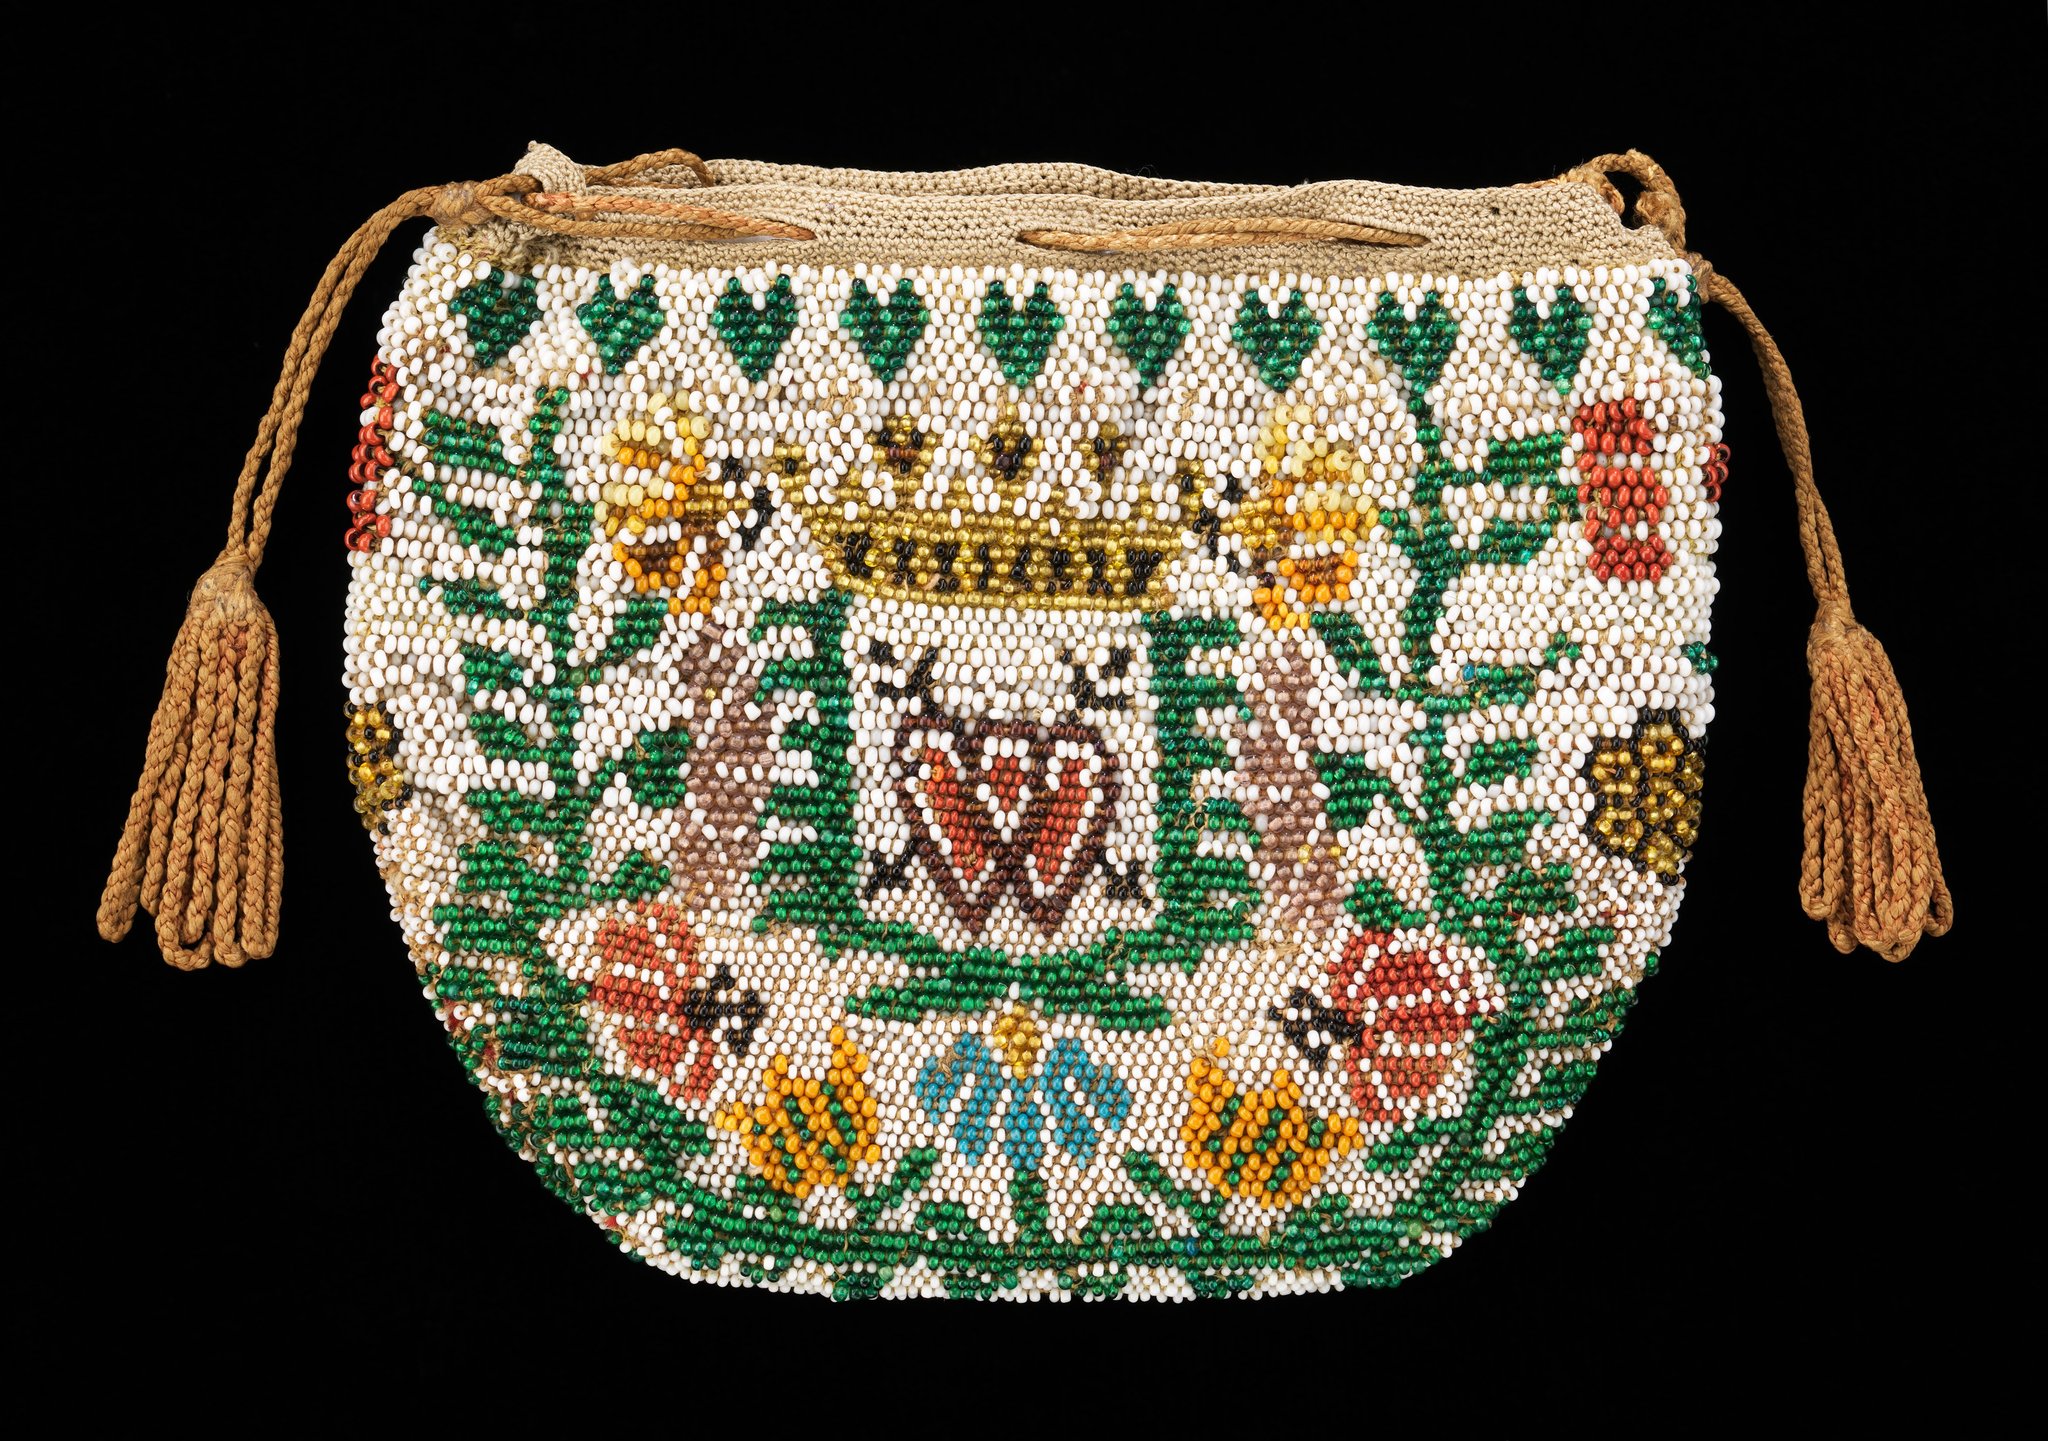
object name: coin purse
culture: british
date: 1780-1810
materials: glass, linen, silk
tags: plants